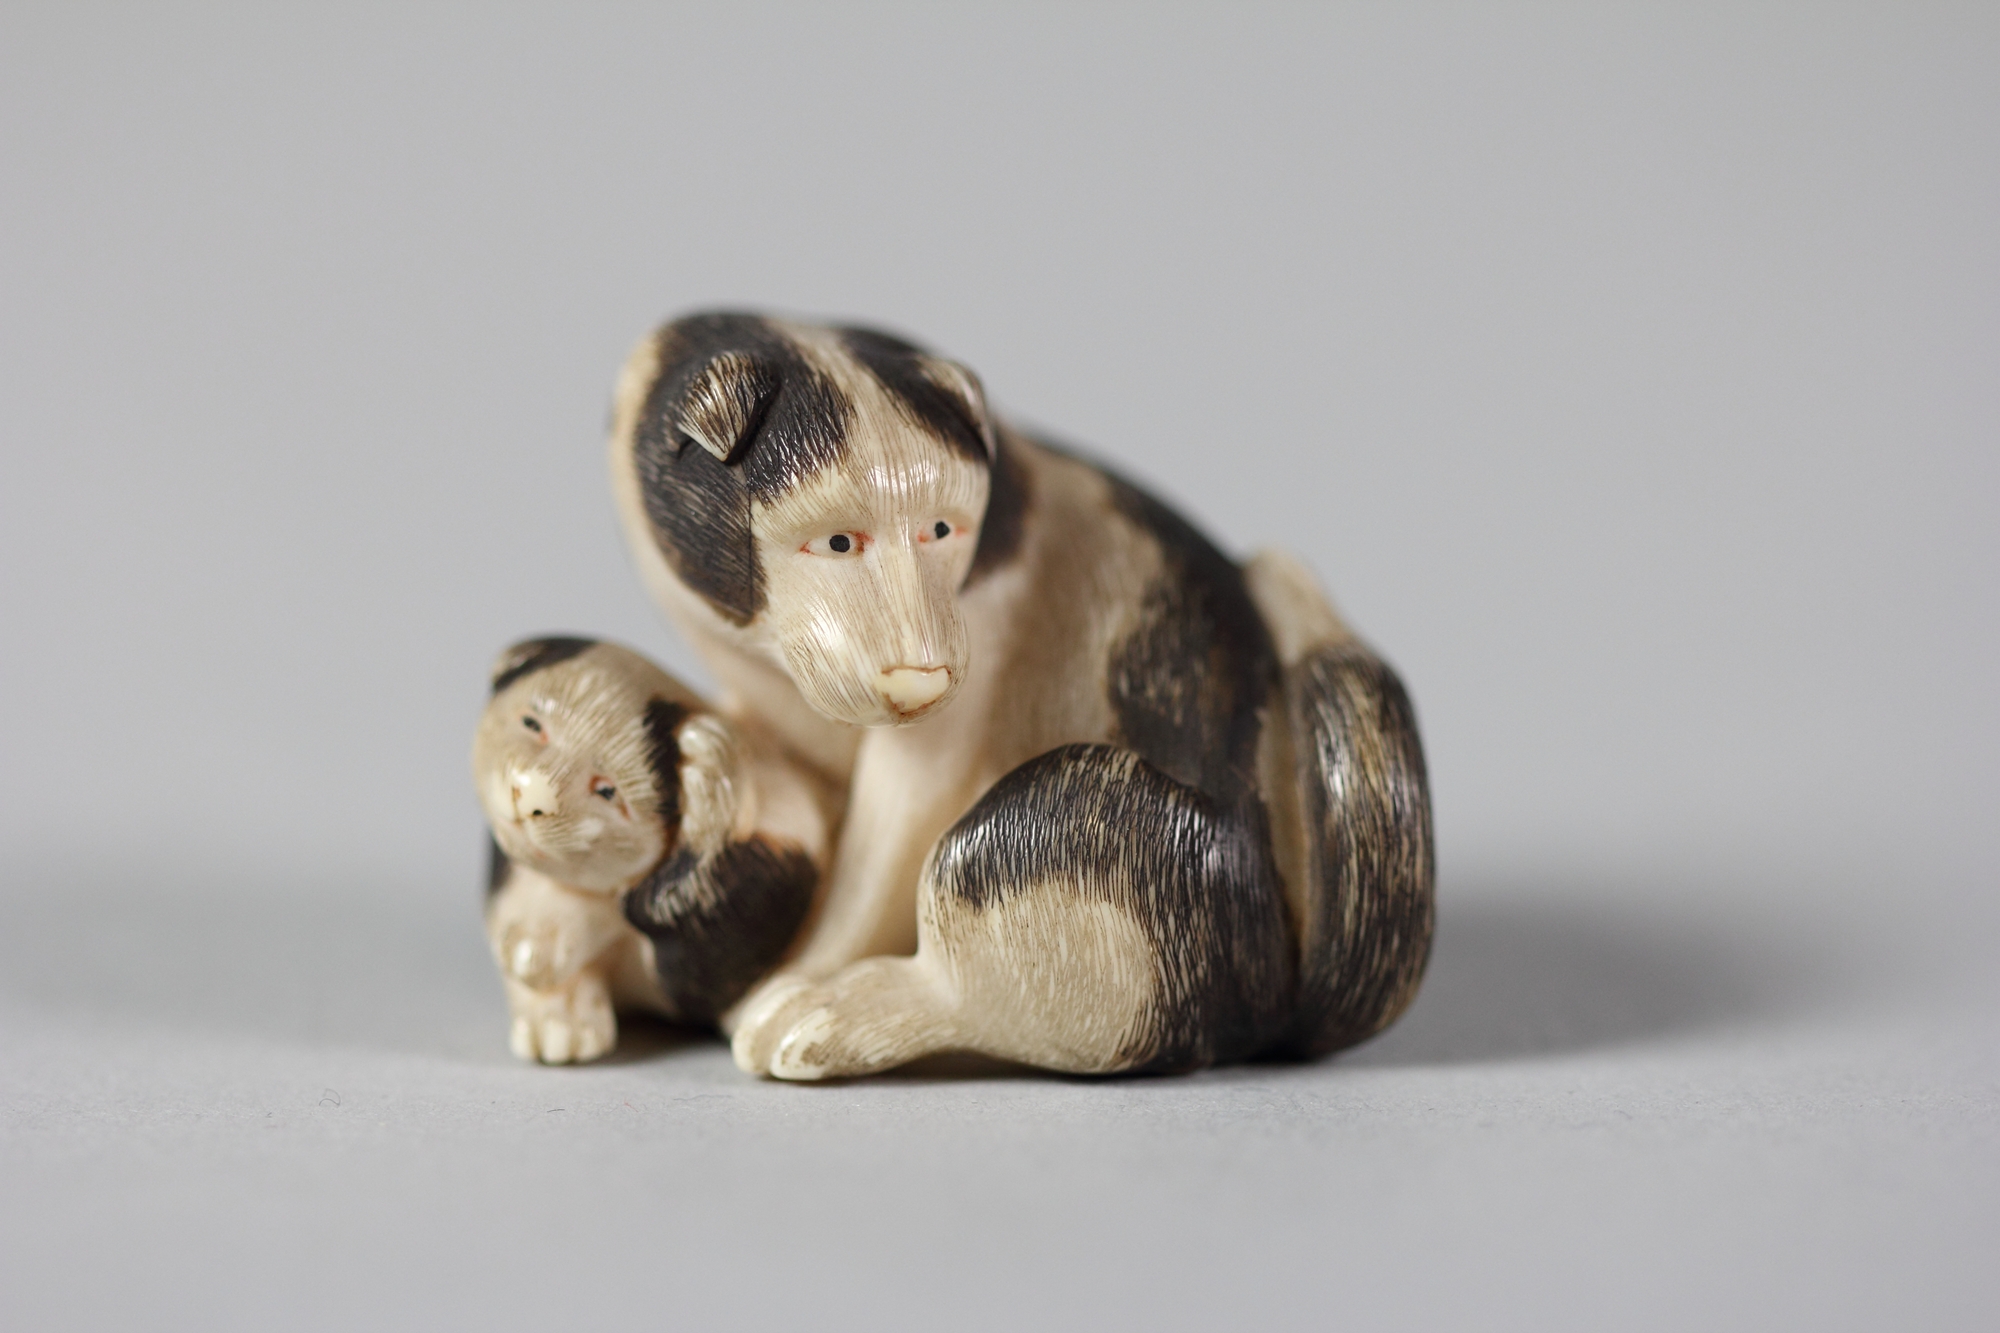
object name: netsuke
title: Dogs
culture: japanese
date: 1801-1900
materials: ivory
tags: dogs